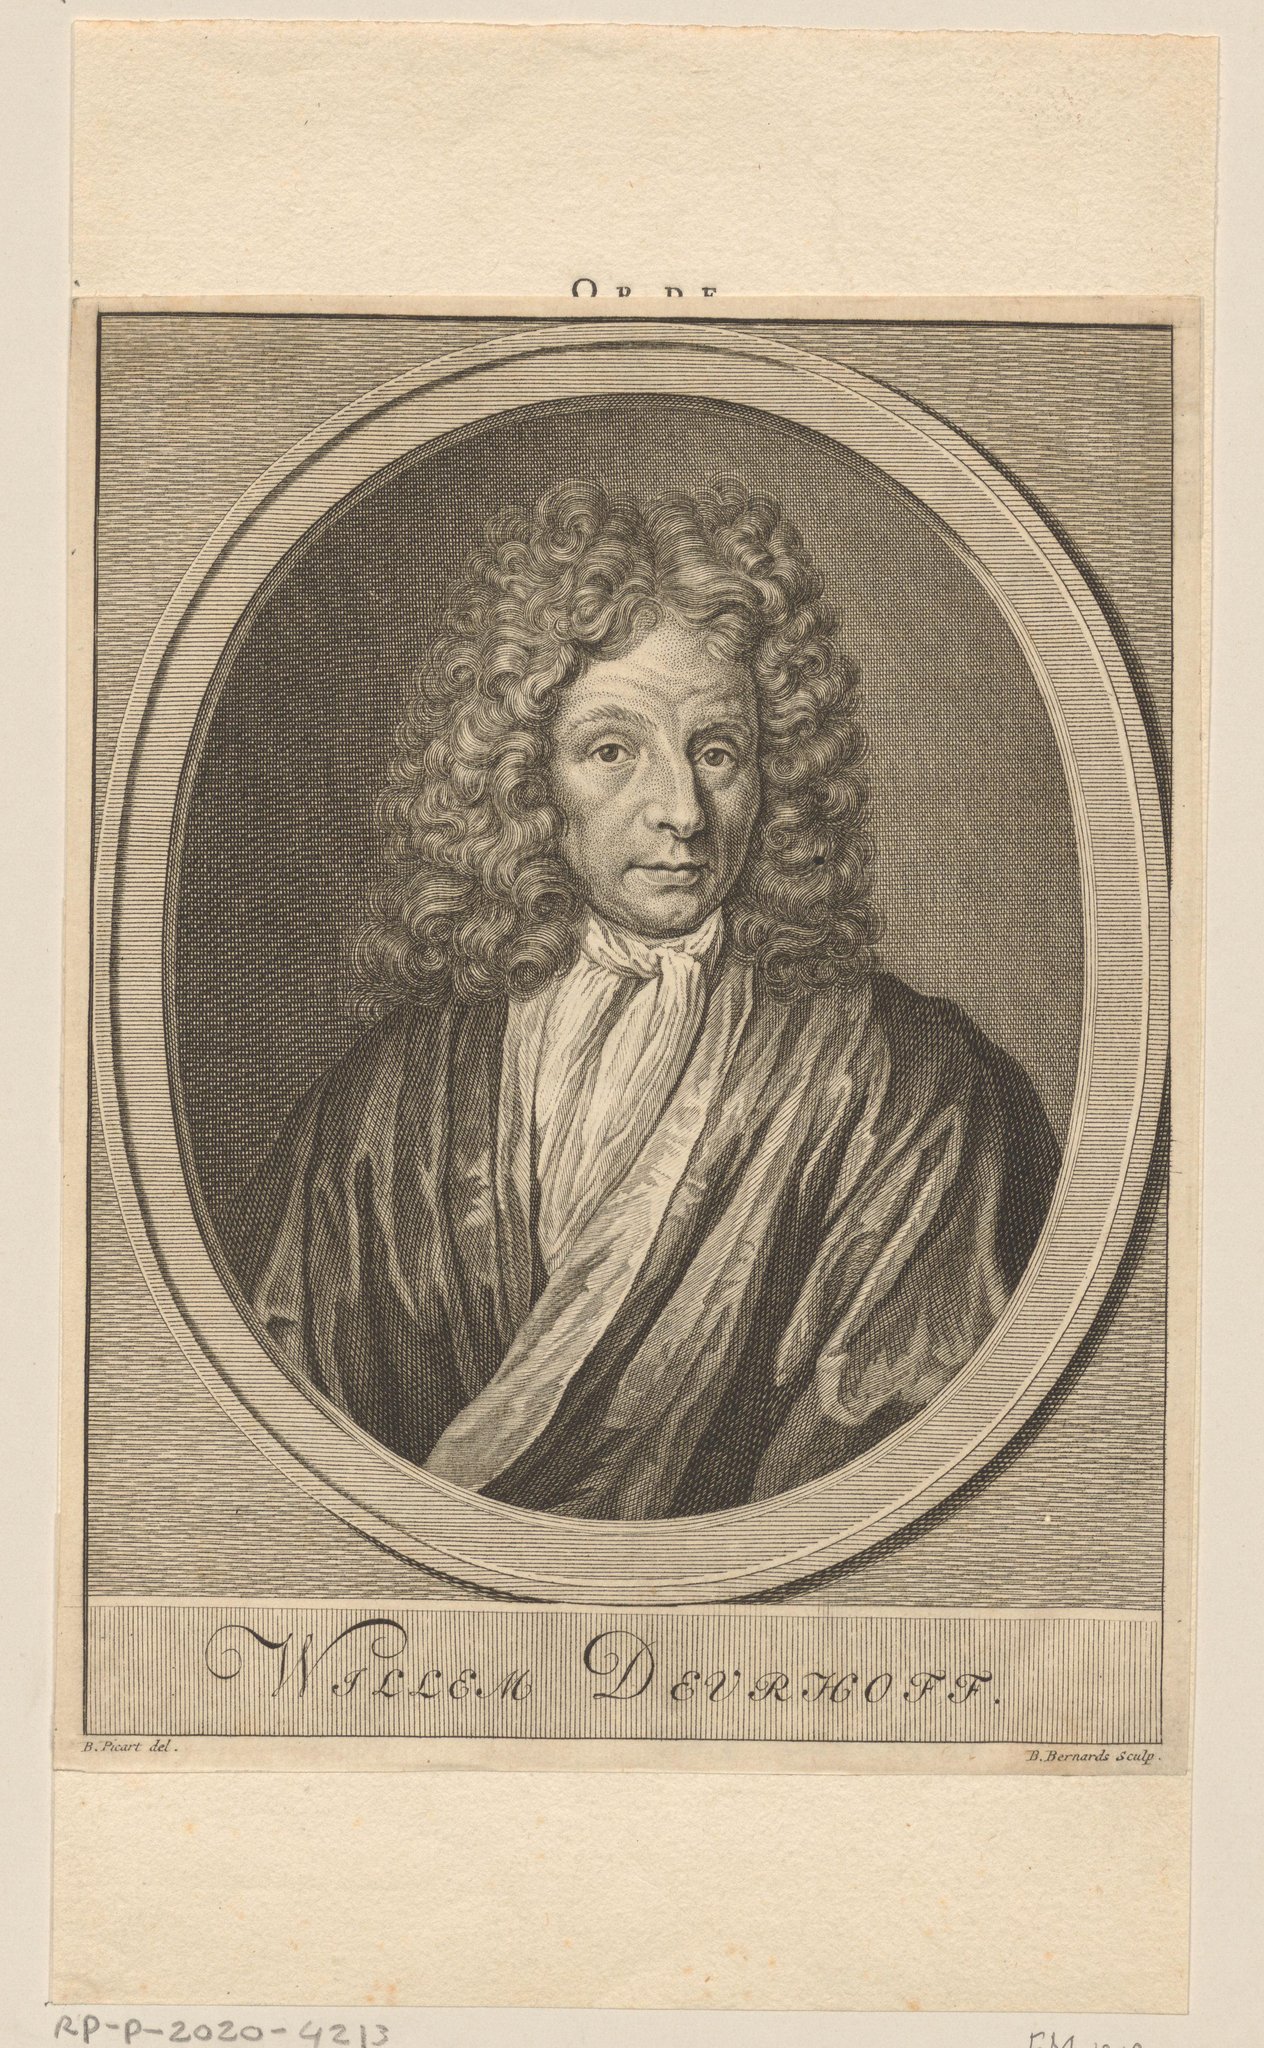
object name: print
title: Portret van Willem Deurhoff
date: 1711-1732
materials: paper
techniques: engraving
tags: amsterdam, historical persons, portrait of a writer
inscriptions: collector's mark: Lugt 240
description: Bij deze prent hoort een tekstblad met een tekst van Hendrik Graauwhart, zie gerelateerd object.